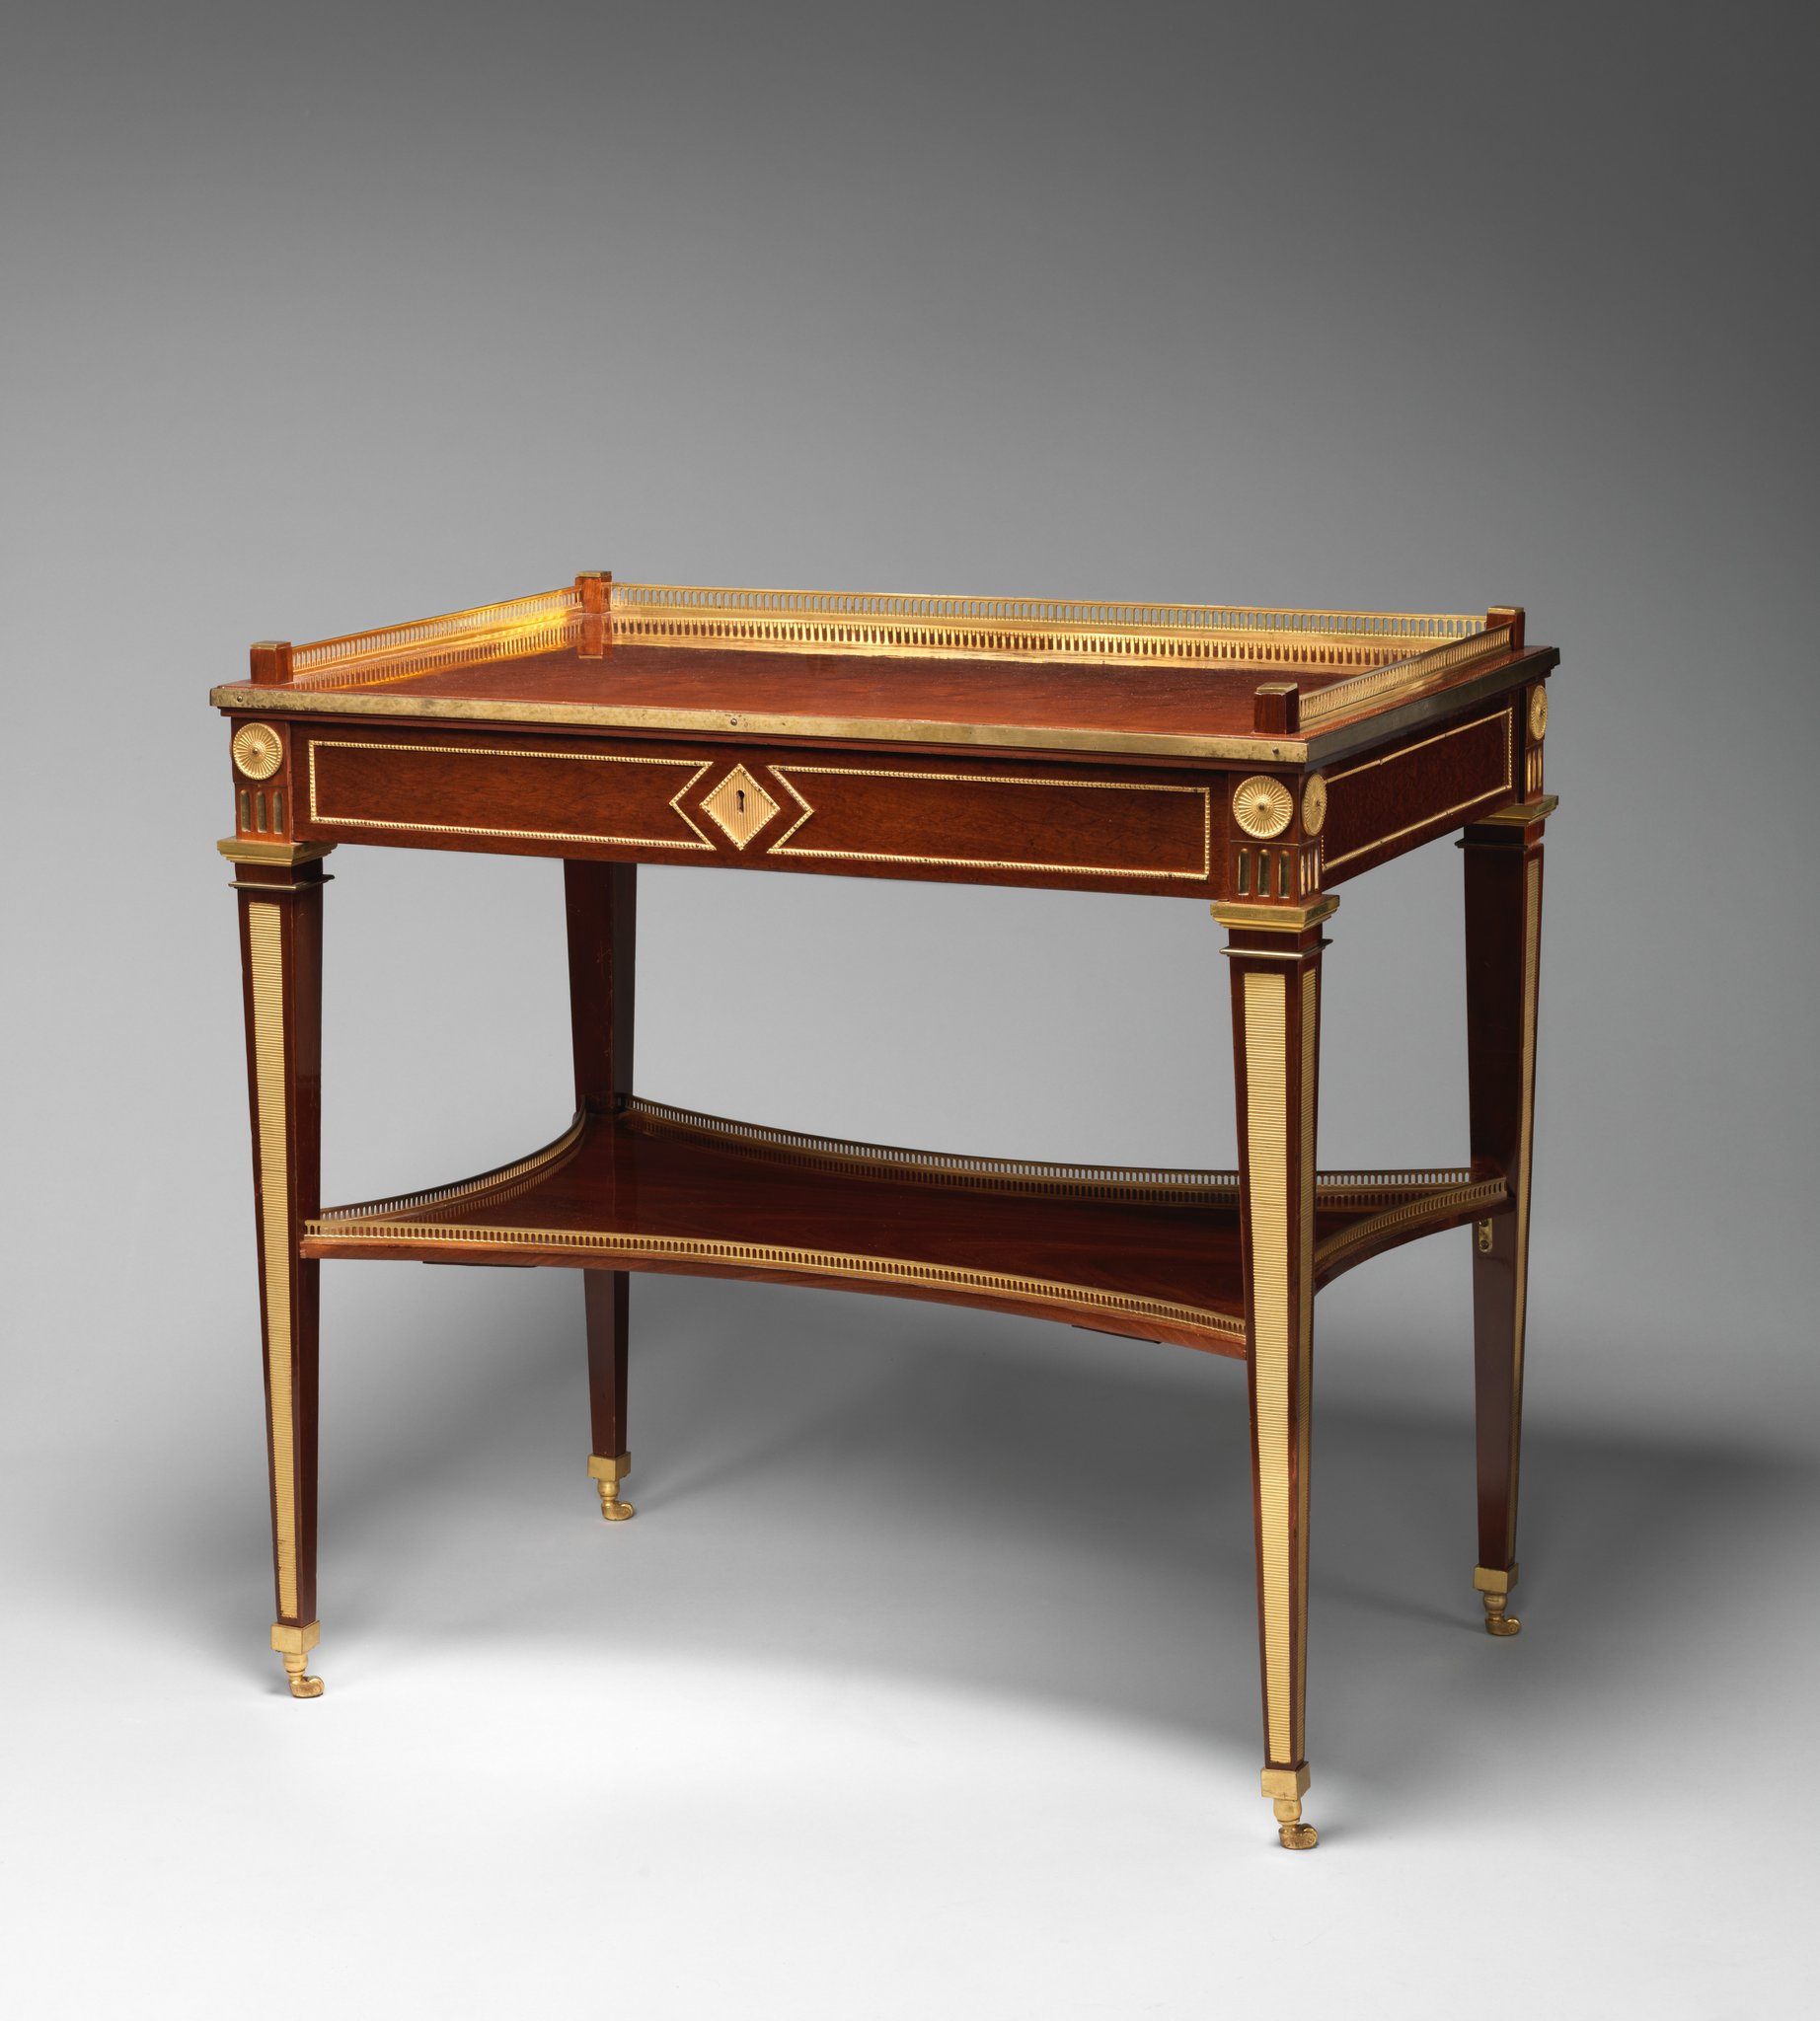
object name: table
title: Writing table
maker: david roentgen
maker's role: maker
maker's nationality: german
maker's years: 1743-1807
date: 1790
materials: gilt bronze, wood